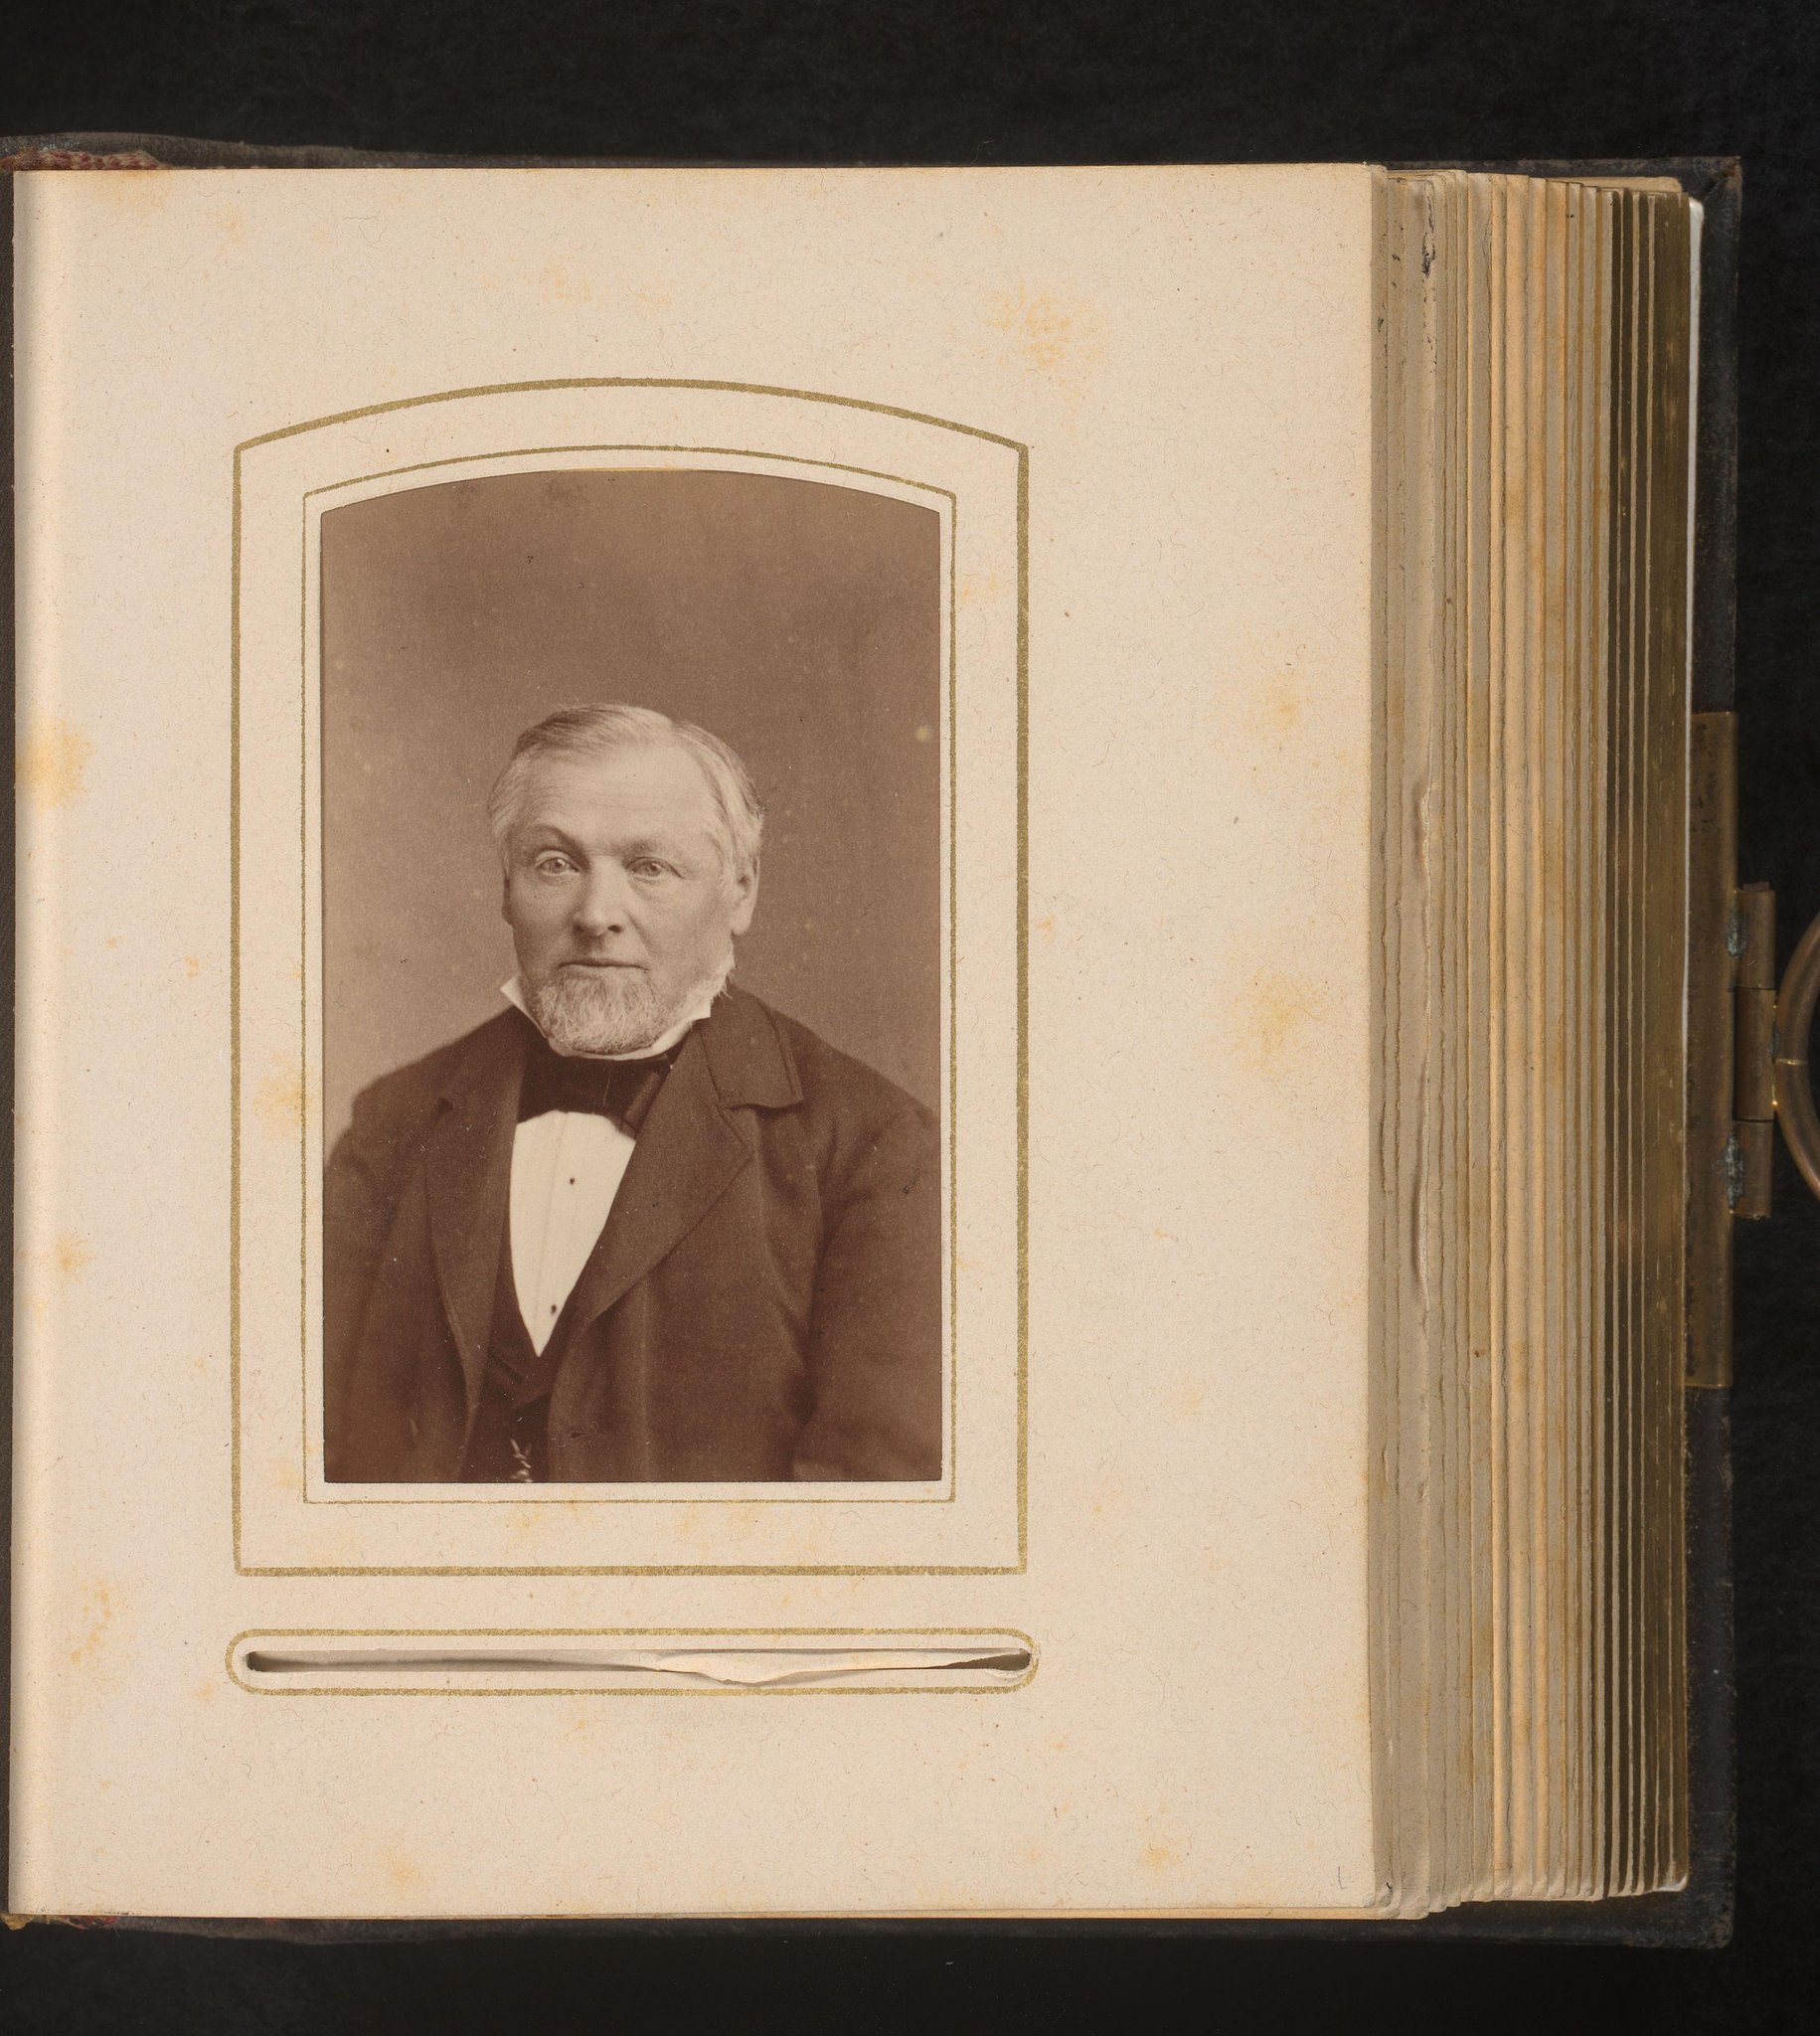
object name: photograph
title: Portret van een man met baard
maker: carl johann friedrich martfeld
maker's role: fotograaf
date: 1860-1900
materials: cardboard, photographic support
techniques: albumen print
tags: adult man, historical persons, beard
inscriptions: inscription: ‘Atelier für photographie/ C. Martfeld/ Bremen/ vor dem Steinthor/ nahe am Dobben (...)’